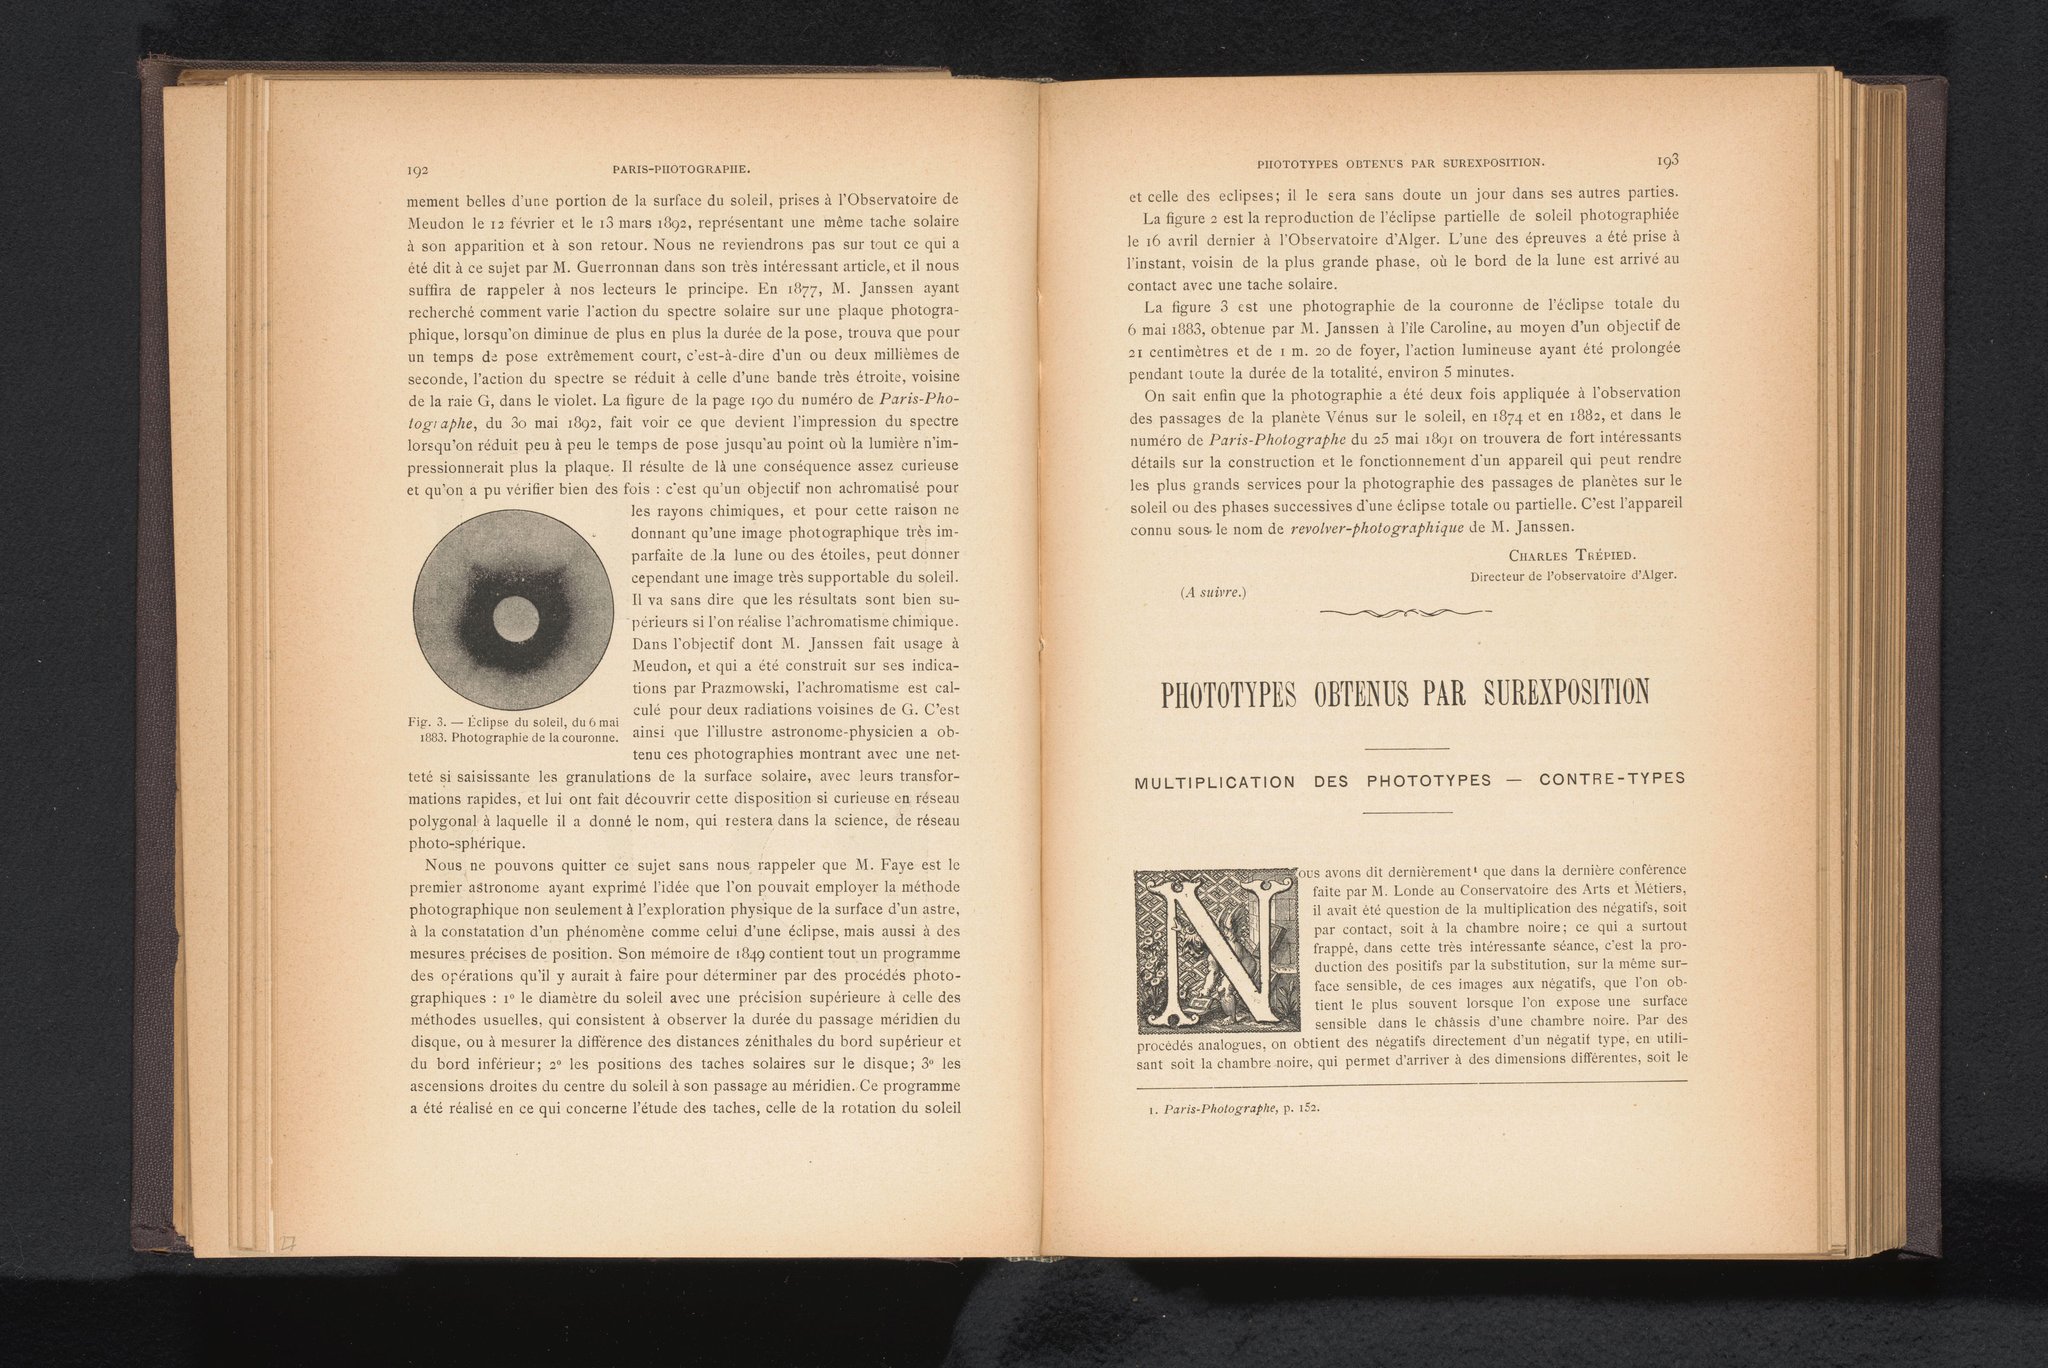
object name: page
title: Zonsverduistering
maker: Anonymous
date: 1883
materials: paper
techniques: autotype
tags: total solar eclipse with corona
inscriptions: number: ‘Fig. 3.’